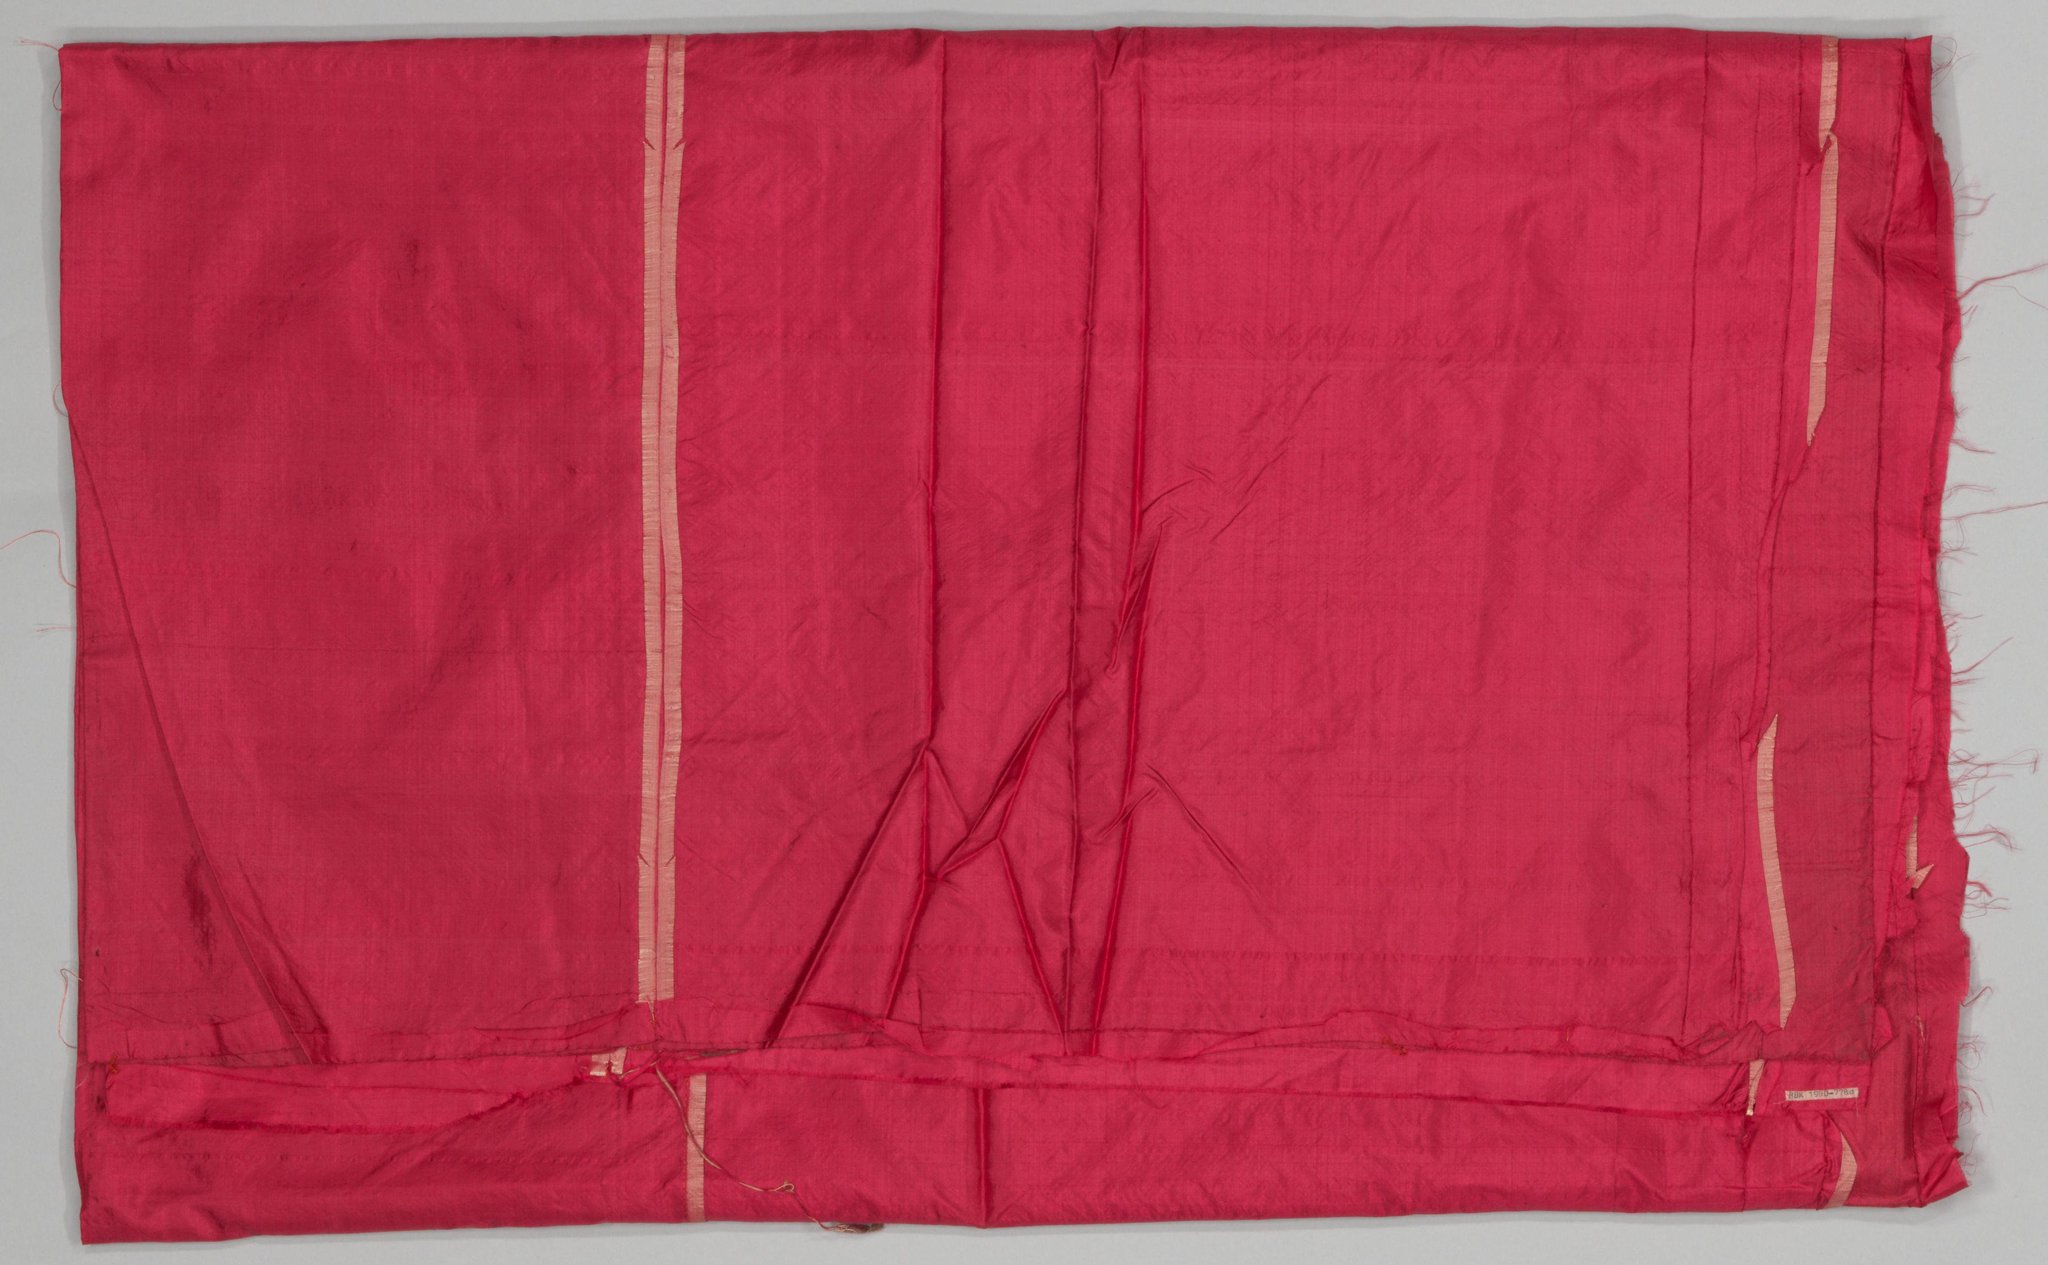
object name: liner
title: Voering van rode zijde, behorend bij een gordijn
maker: Anonymous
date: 1830-1870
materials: silk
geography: france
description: Voering van rode zijde, behorend bij een gordijn (zie A en B).